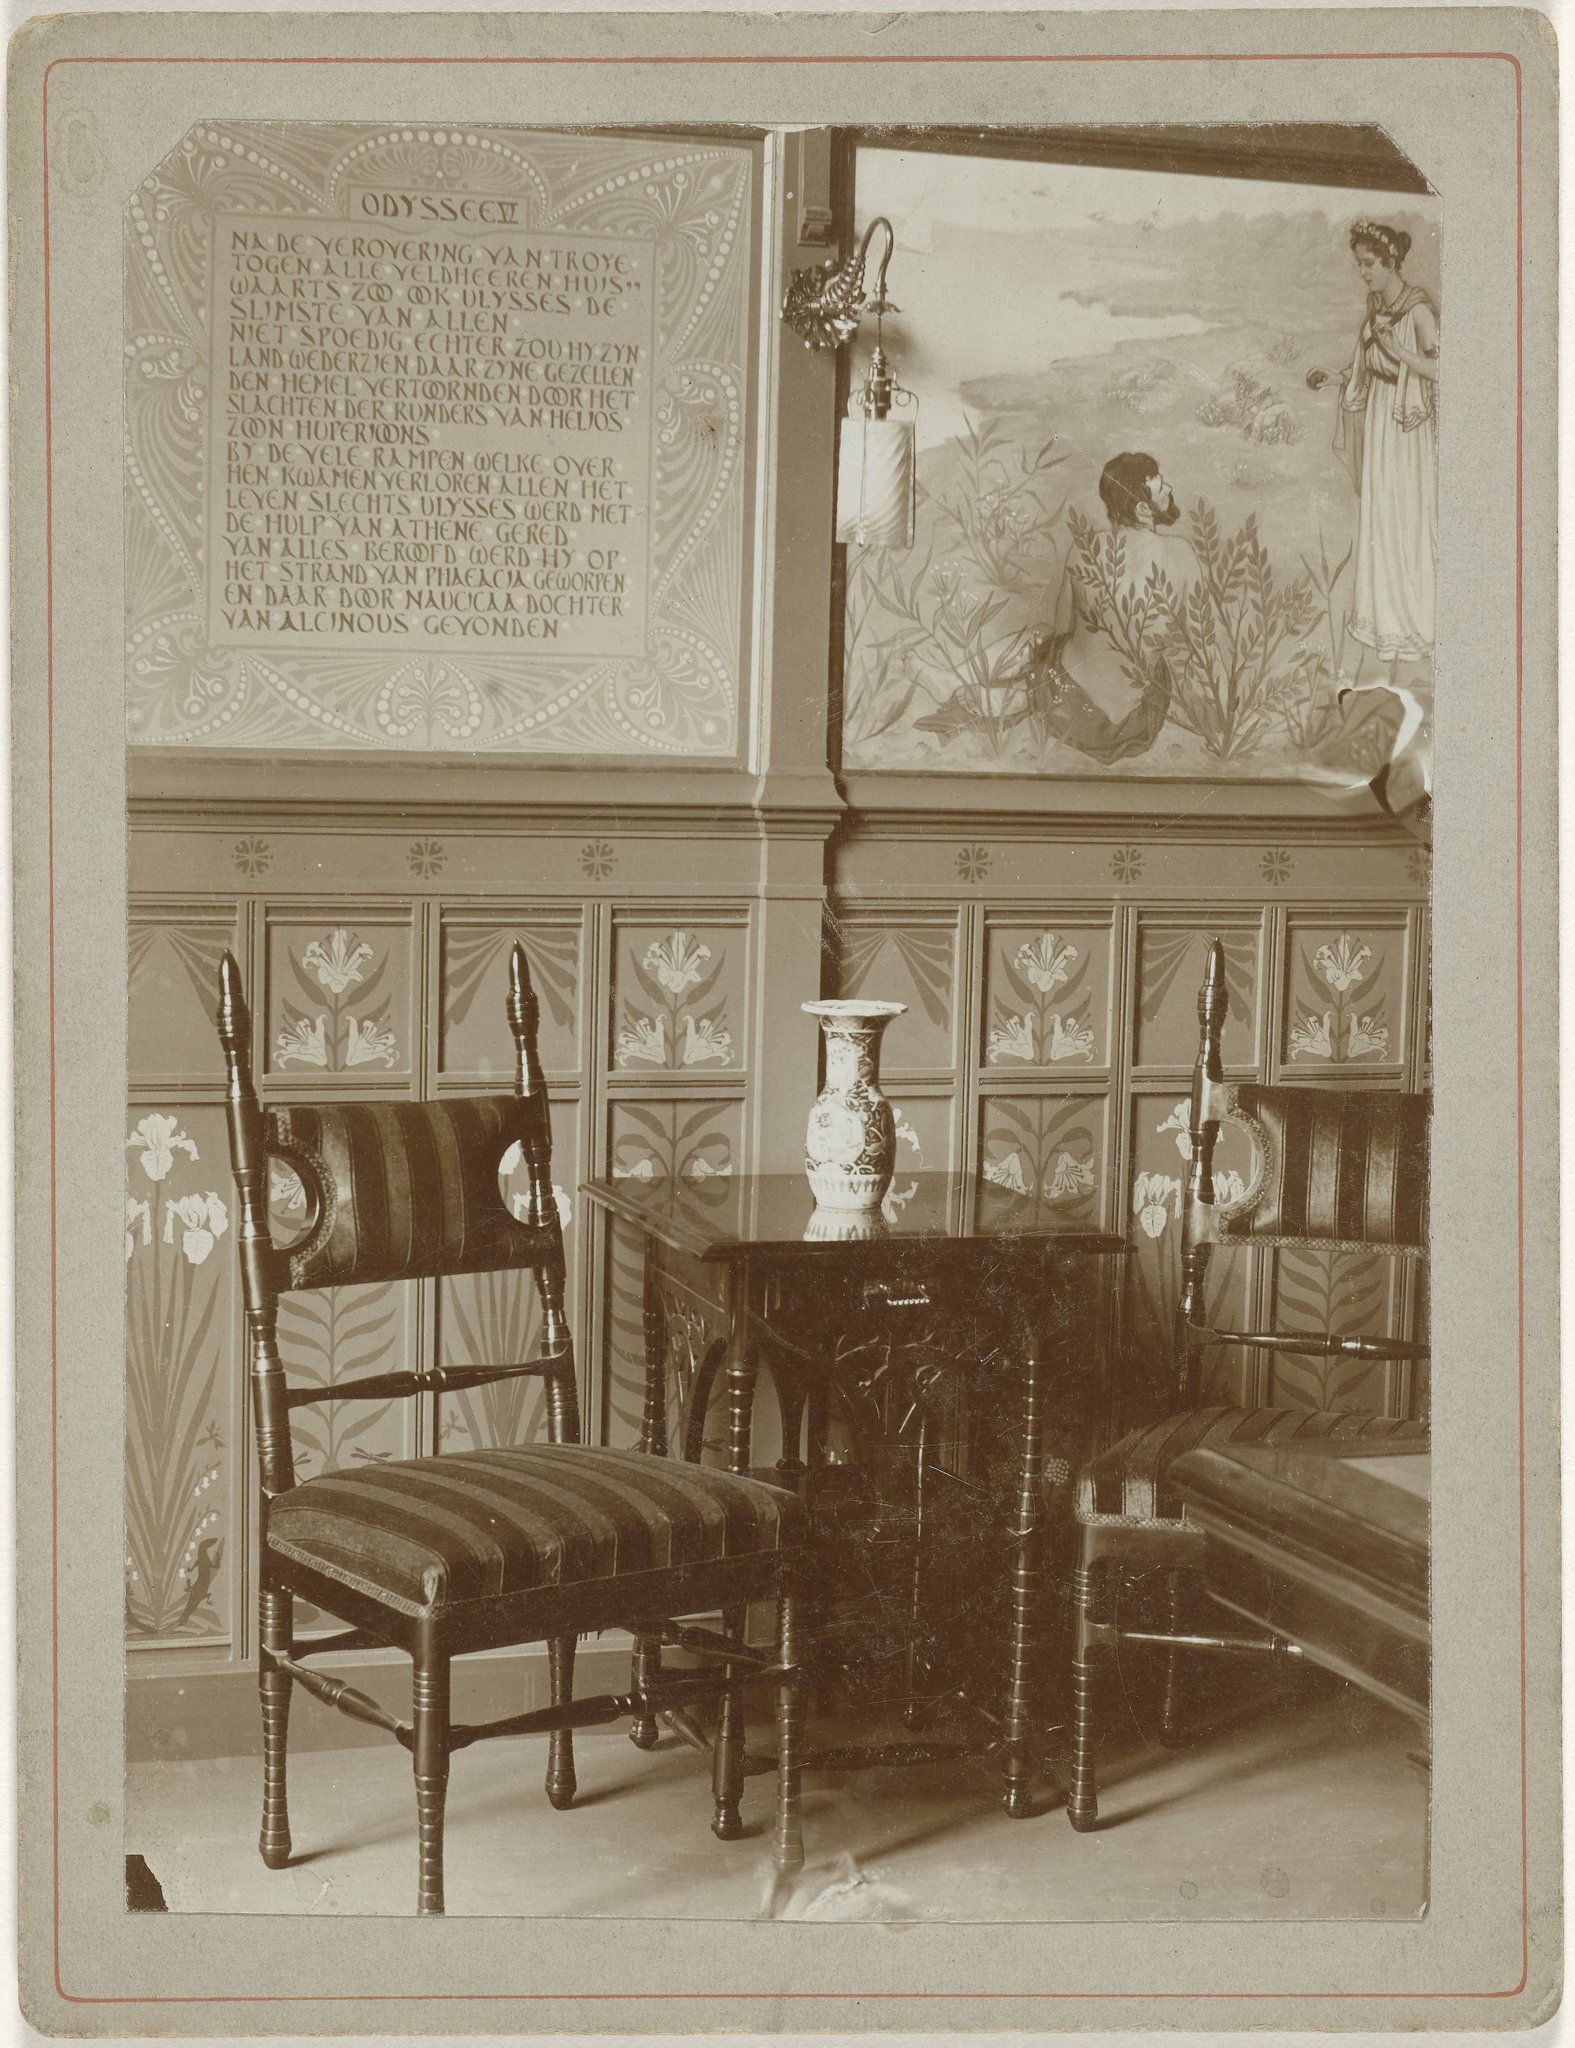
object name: photograph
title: Art-Nouveau interieur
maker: Anonymous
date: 1890-1910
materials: cardboard, photographic support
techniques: albumen print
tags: interior of the house